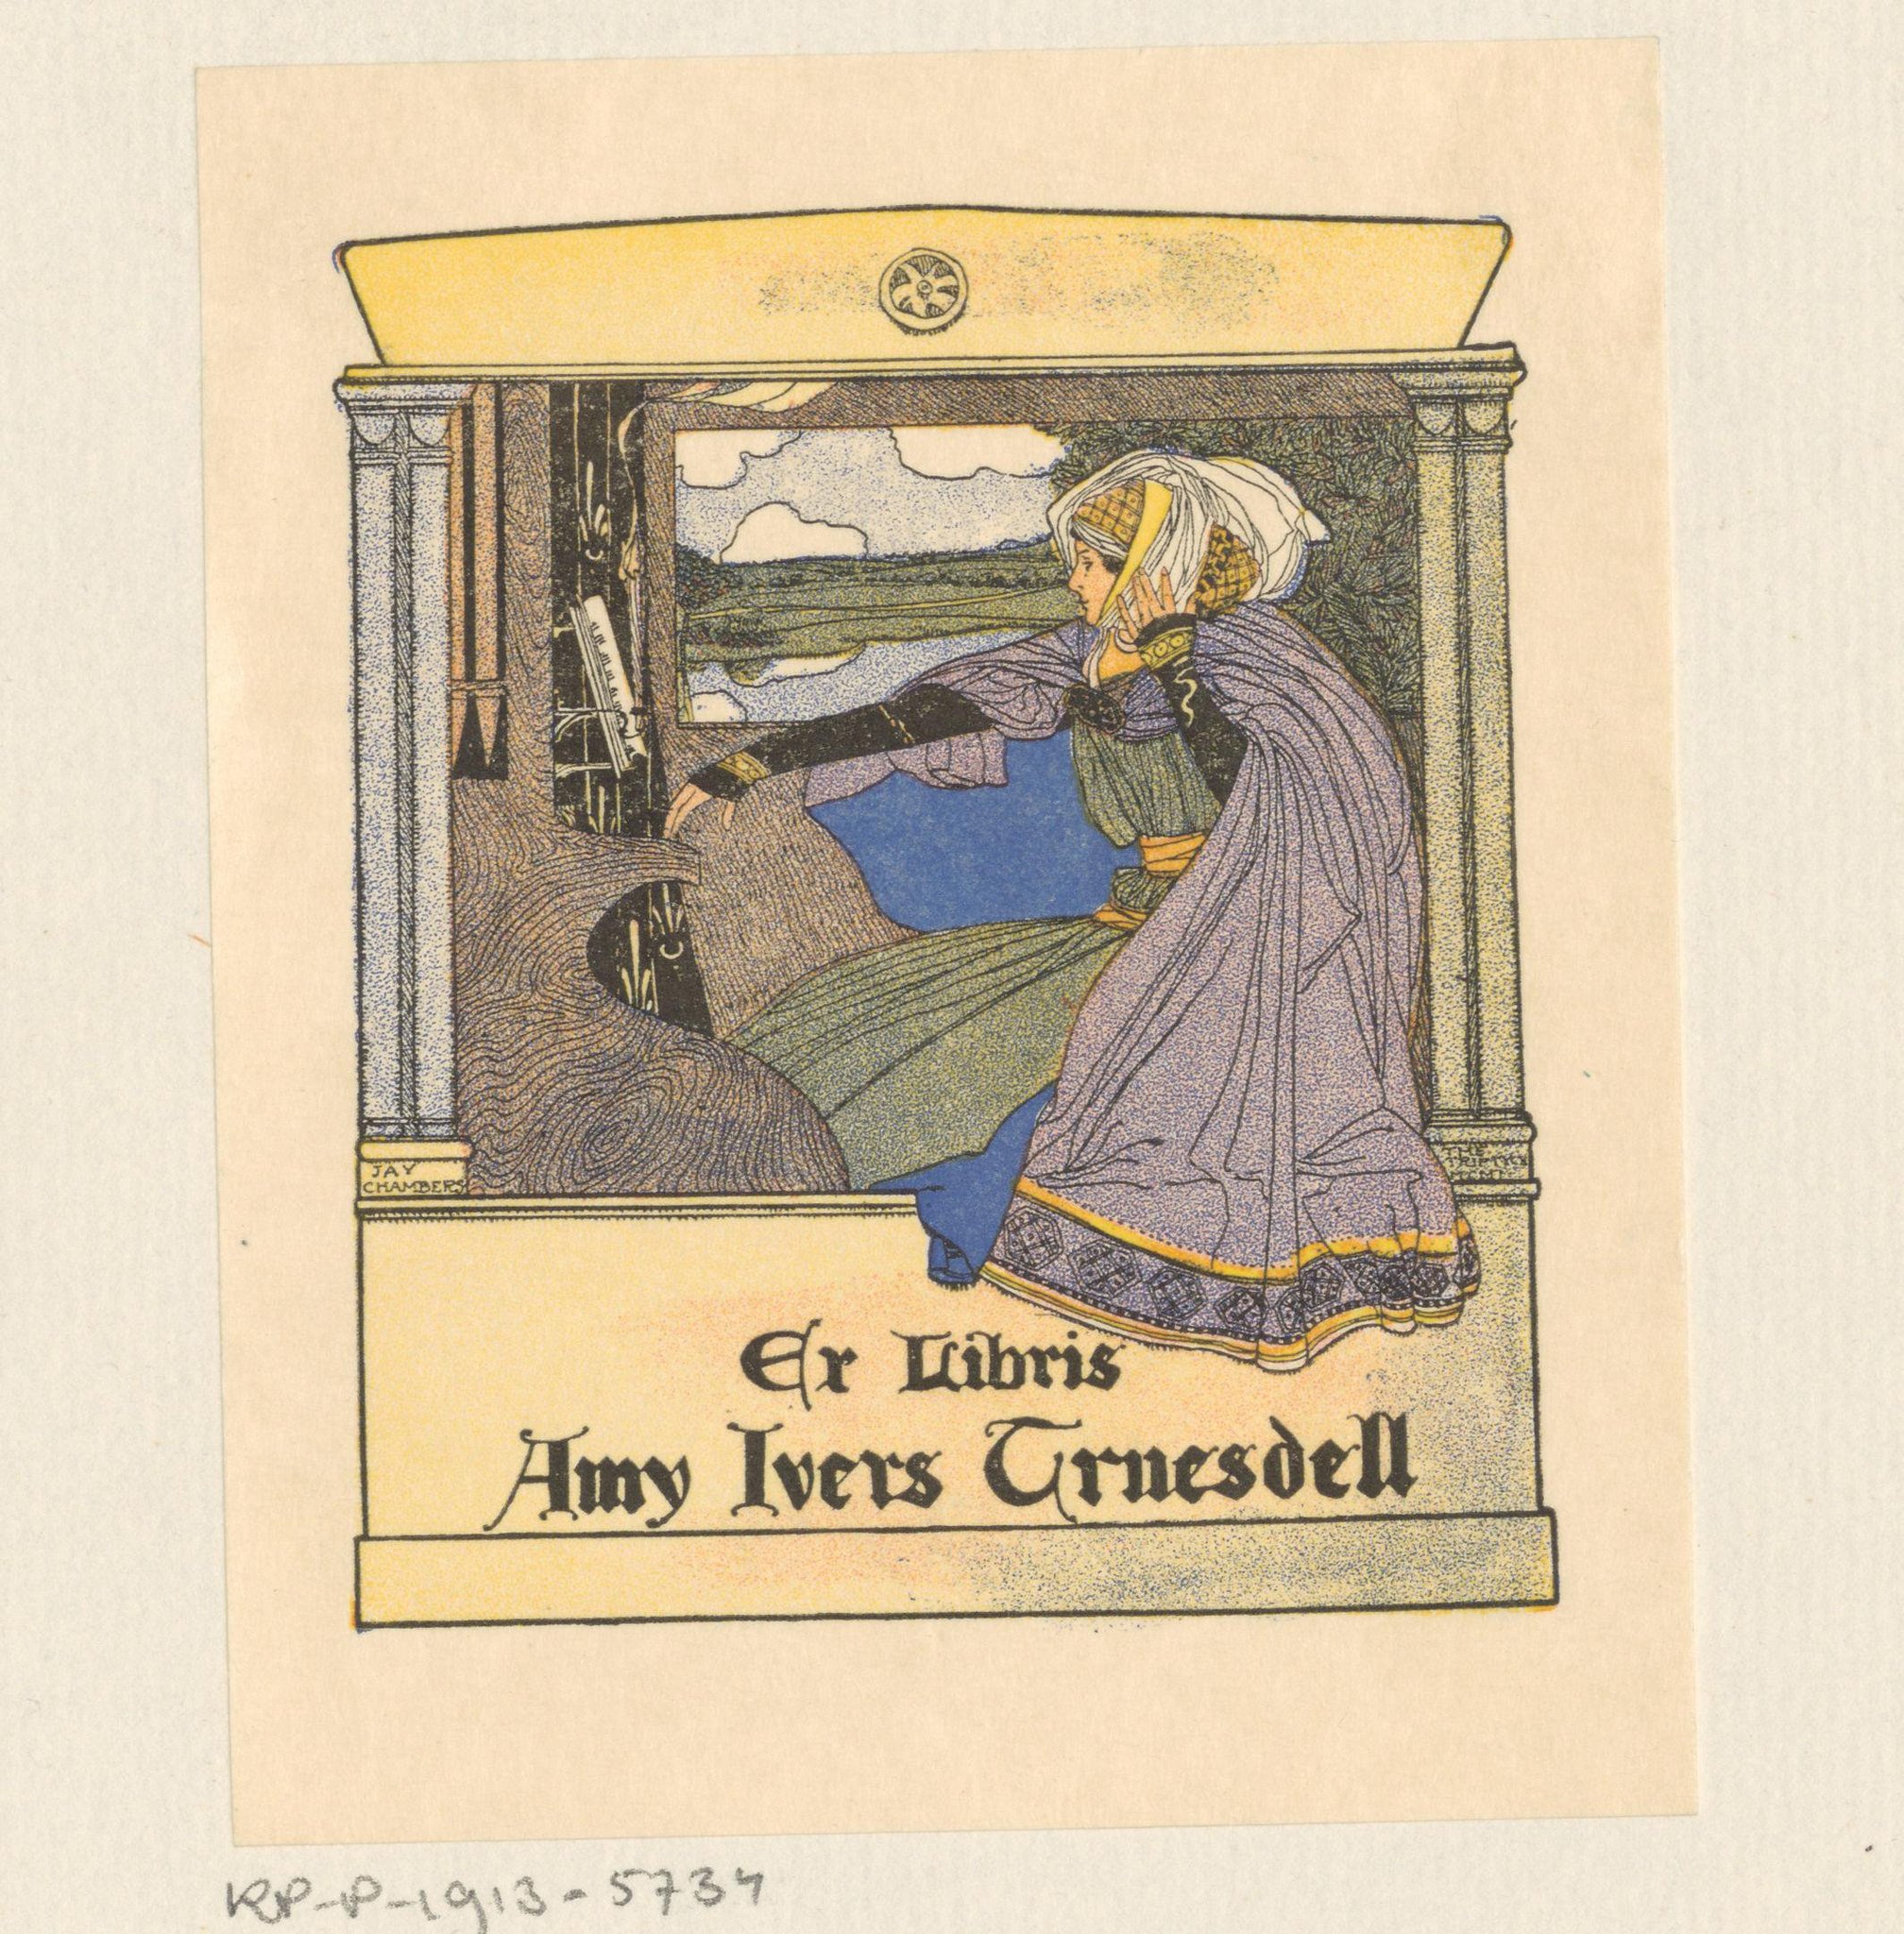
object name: bookplate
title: Ex libris van Amy Ivers Truesdell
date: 1901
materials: paper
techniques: printing block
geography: england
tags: notation of music, landscapes, sitting figure - aa - female human figure, column, pillar ~ architecture, keyboard instruments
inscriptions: collector's mark: Lugt 2760, collector's mark: Lugt 2233